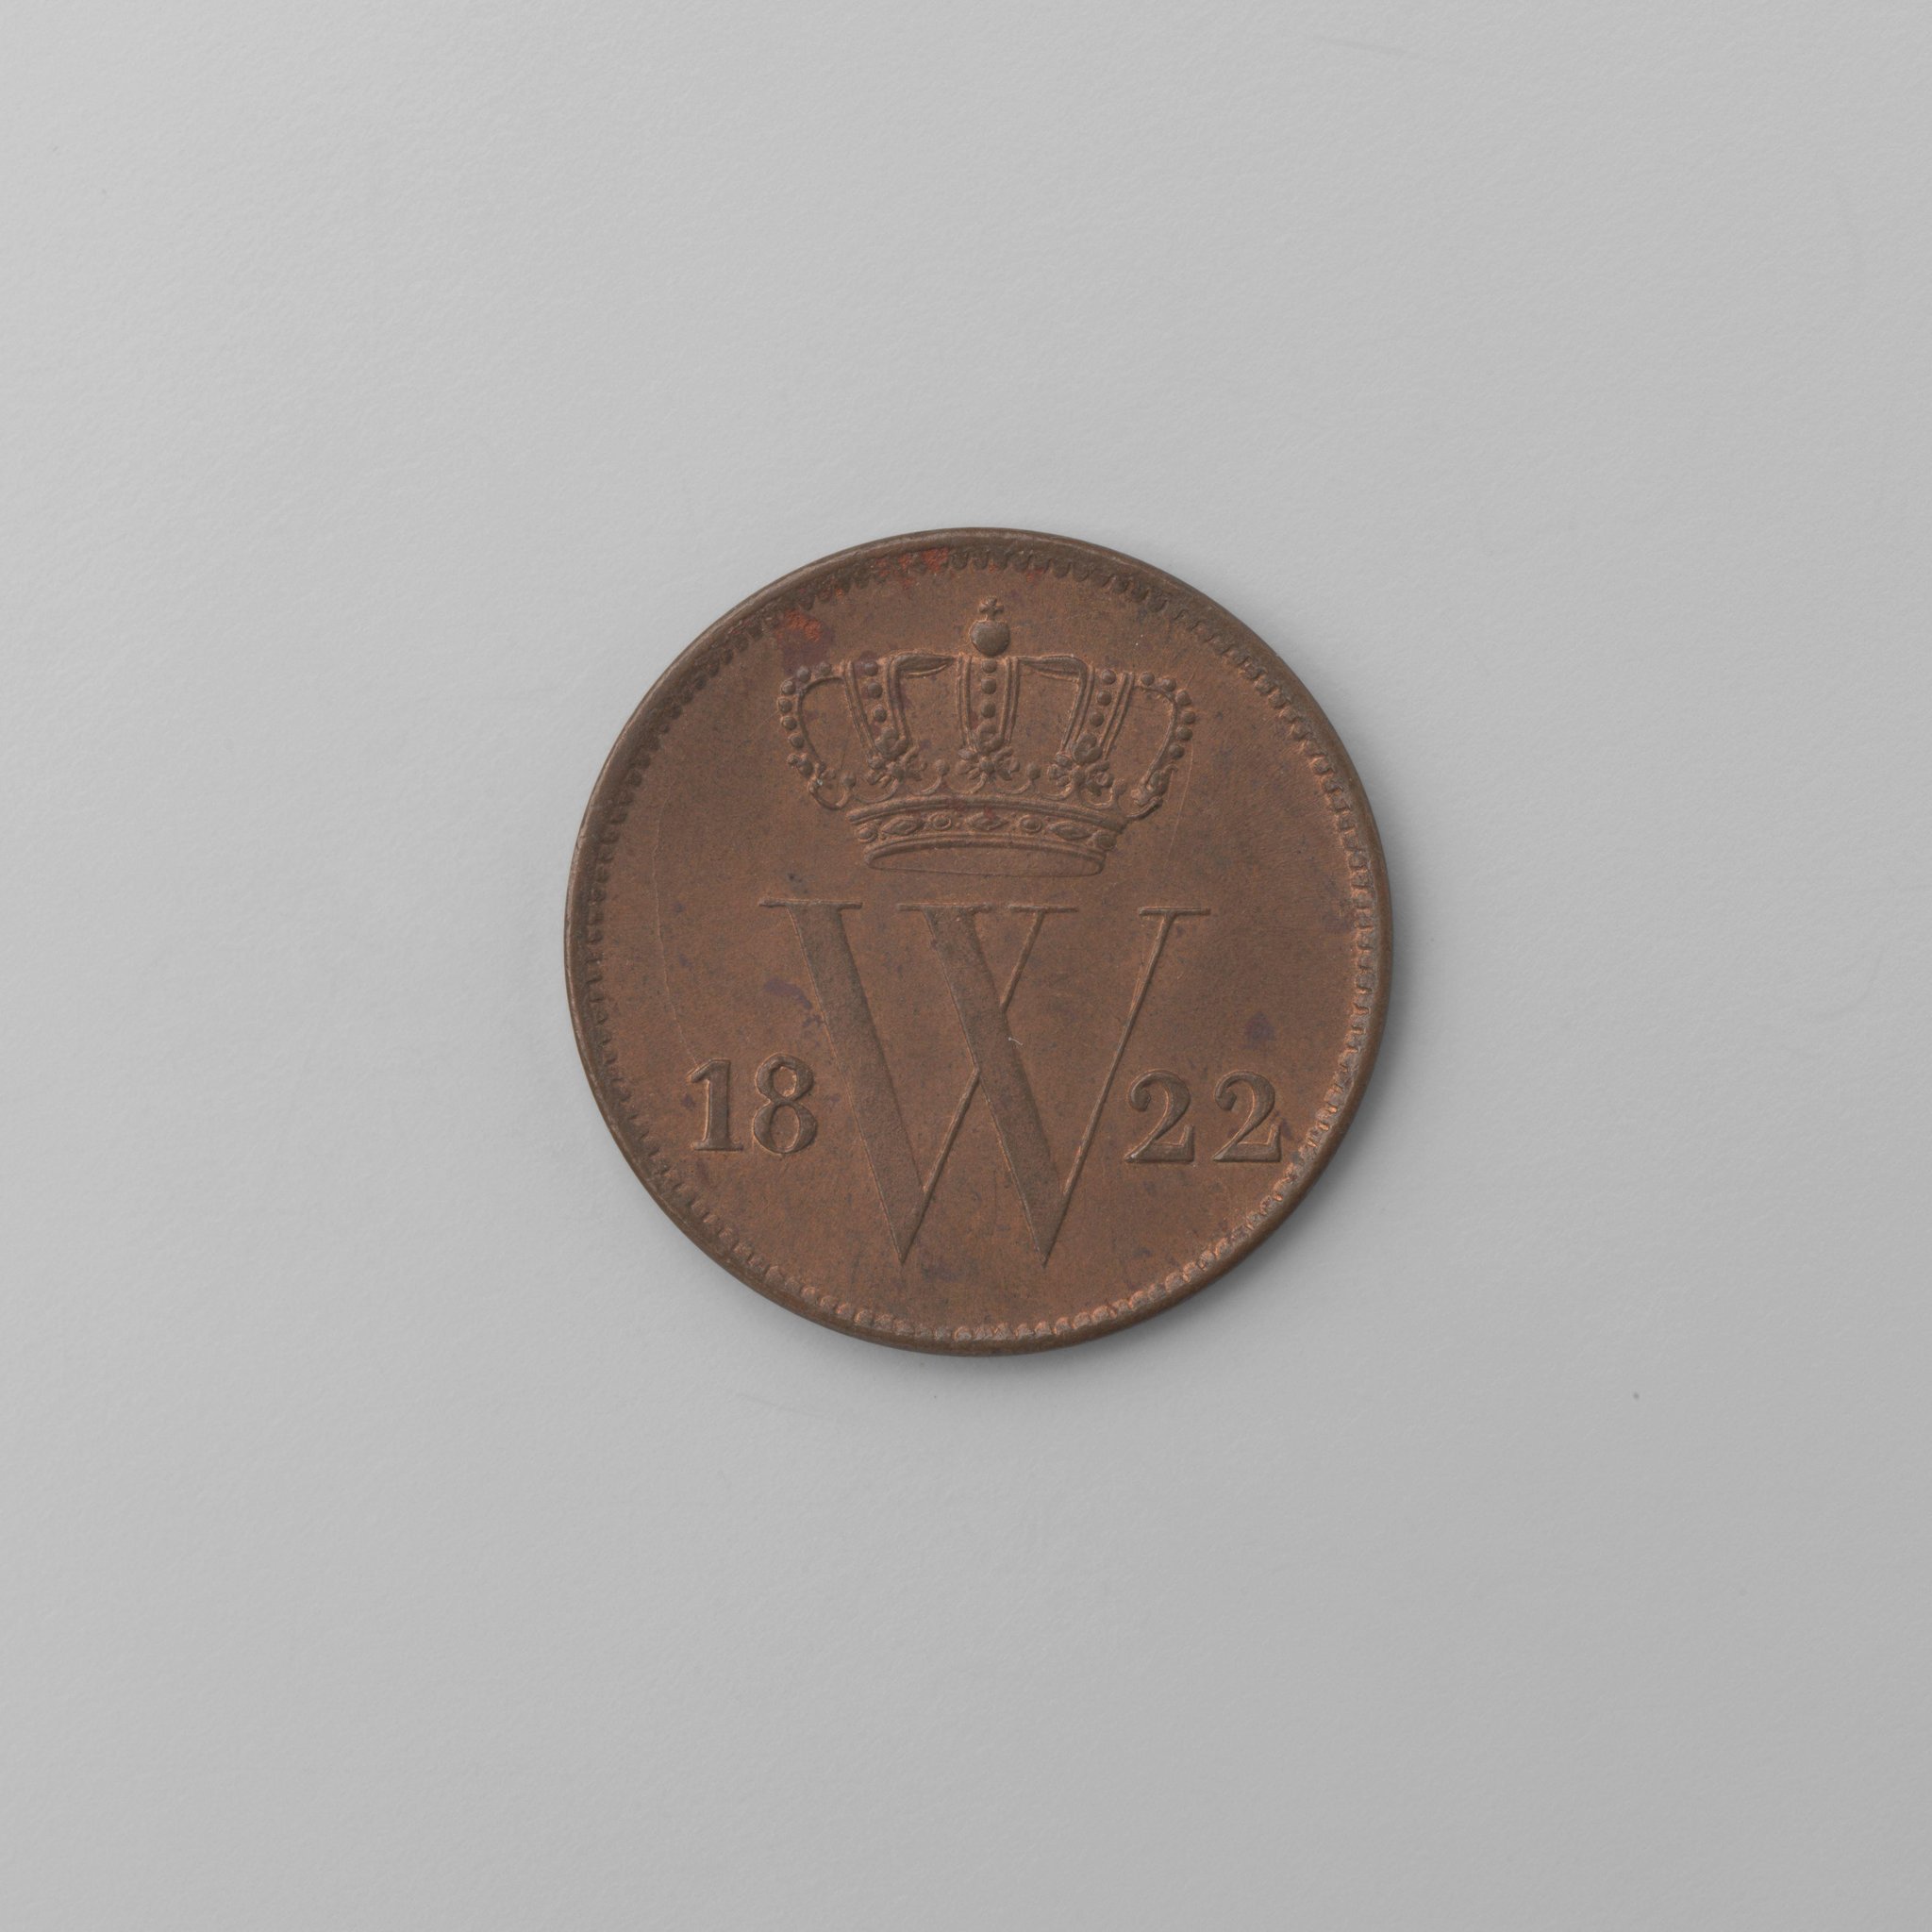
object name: coin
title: Nederlandse cent, 1822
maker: william i of the netherlands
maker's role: koning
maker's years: 1772-1843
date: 1822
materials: copper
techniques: striking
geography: utrecht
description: Koperen munt. Voorzijde: tussen jaartal gekroonde rechte letter W. Keerzijde: tussen waarde-aanduiding 1 C. gekroond rijkswapenschild. Gladde rand.